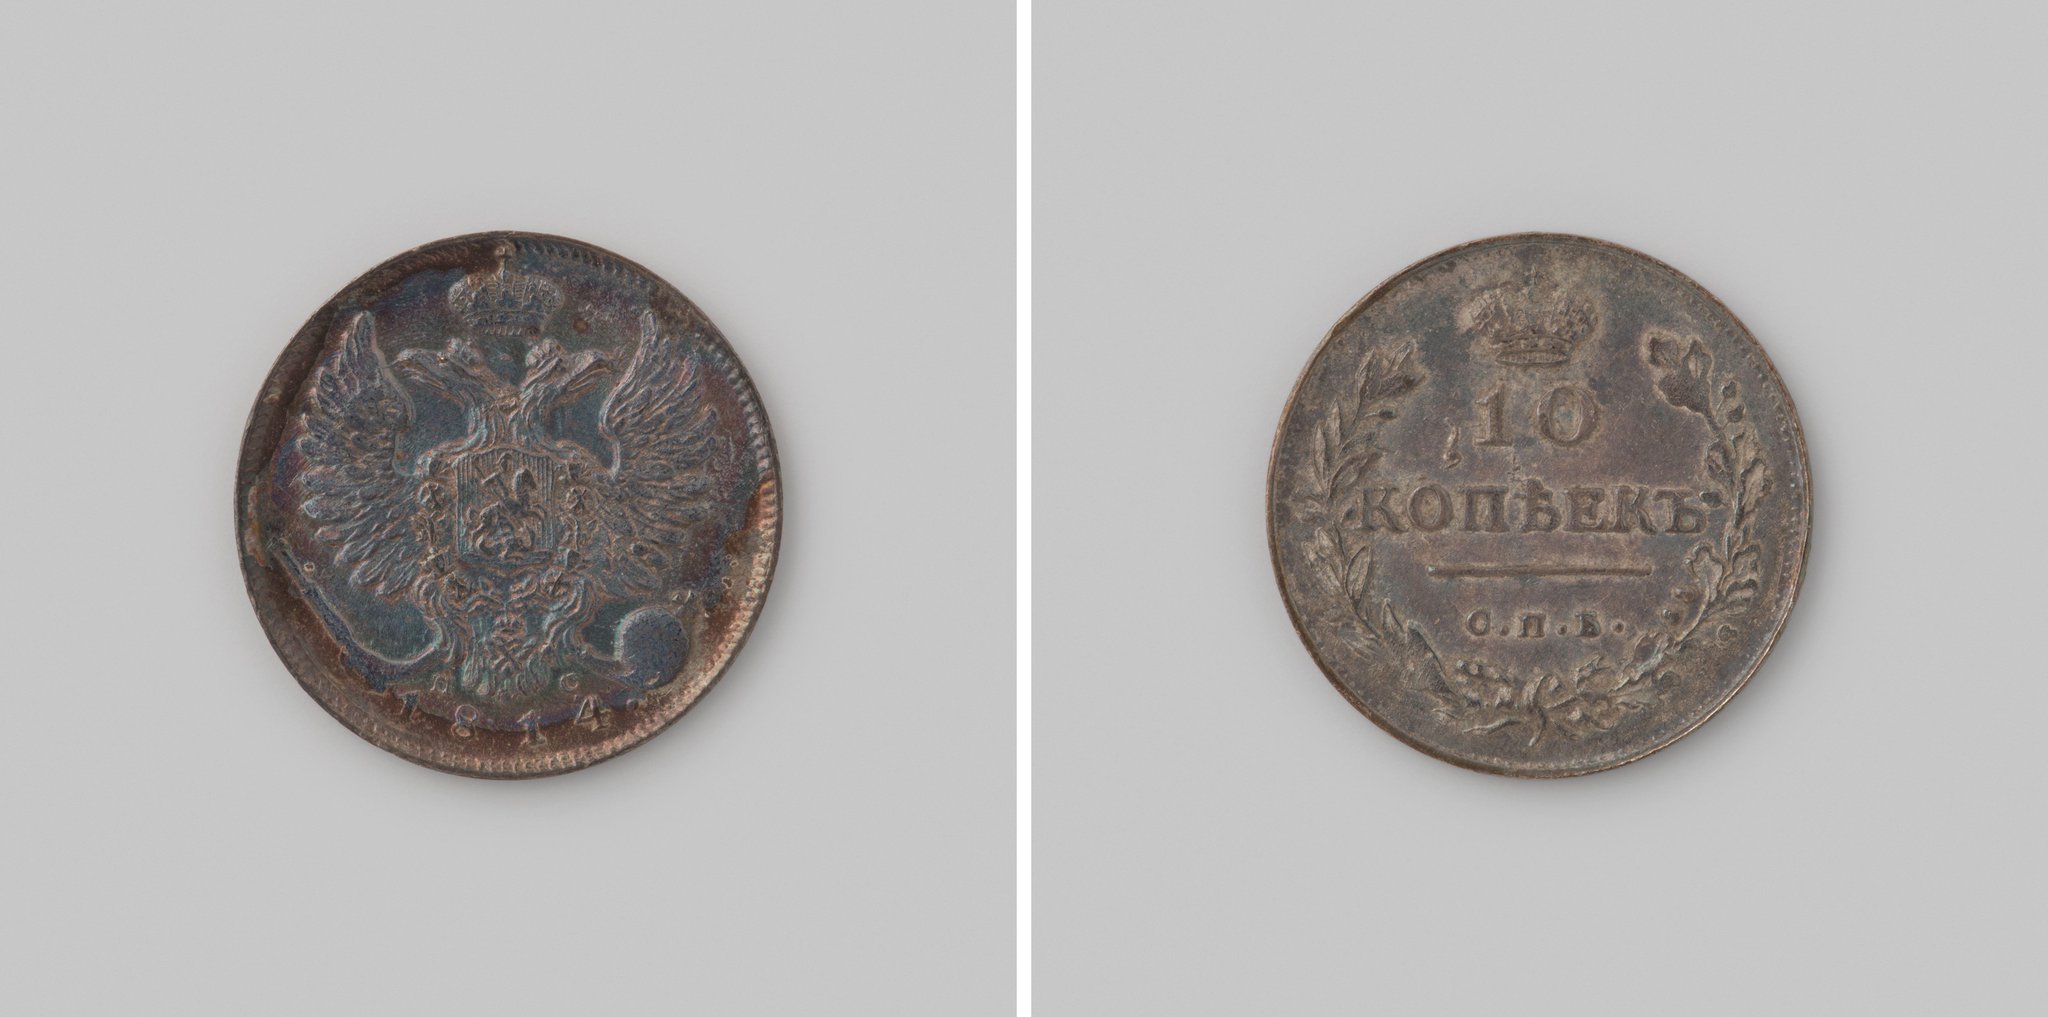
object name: coin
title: Rusland, tsaar Alexander I, 10 kopeken, 1814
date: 1814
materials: silver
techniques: striking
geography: sint-petersburg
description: Zilveren munt. Voorzijde: dubbelkoppige gekroonde adelaar met gespreide vleugels, met op zijn borst door ridderorde omhangen wapenschild en met in zijn poten scepter en bol met daarop kruis. Boven de adelaar een kroon. Jaartal onderaan. Keerzijde: binnen twee samengebonden takken onder een kroon waarde-aanduiding in twee regels. Daaronder de letters S, P en B in Cyrillisch schrift. Kartelrand.